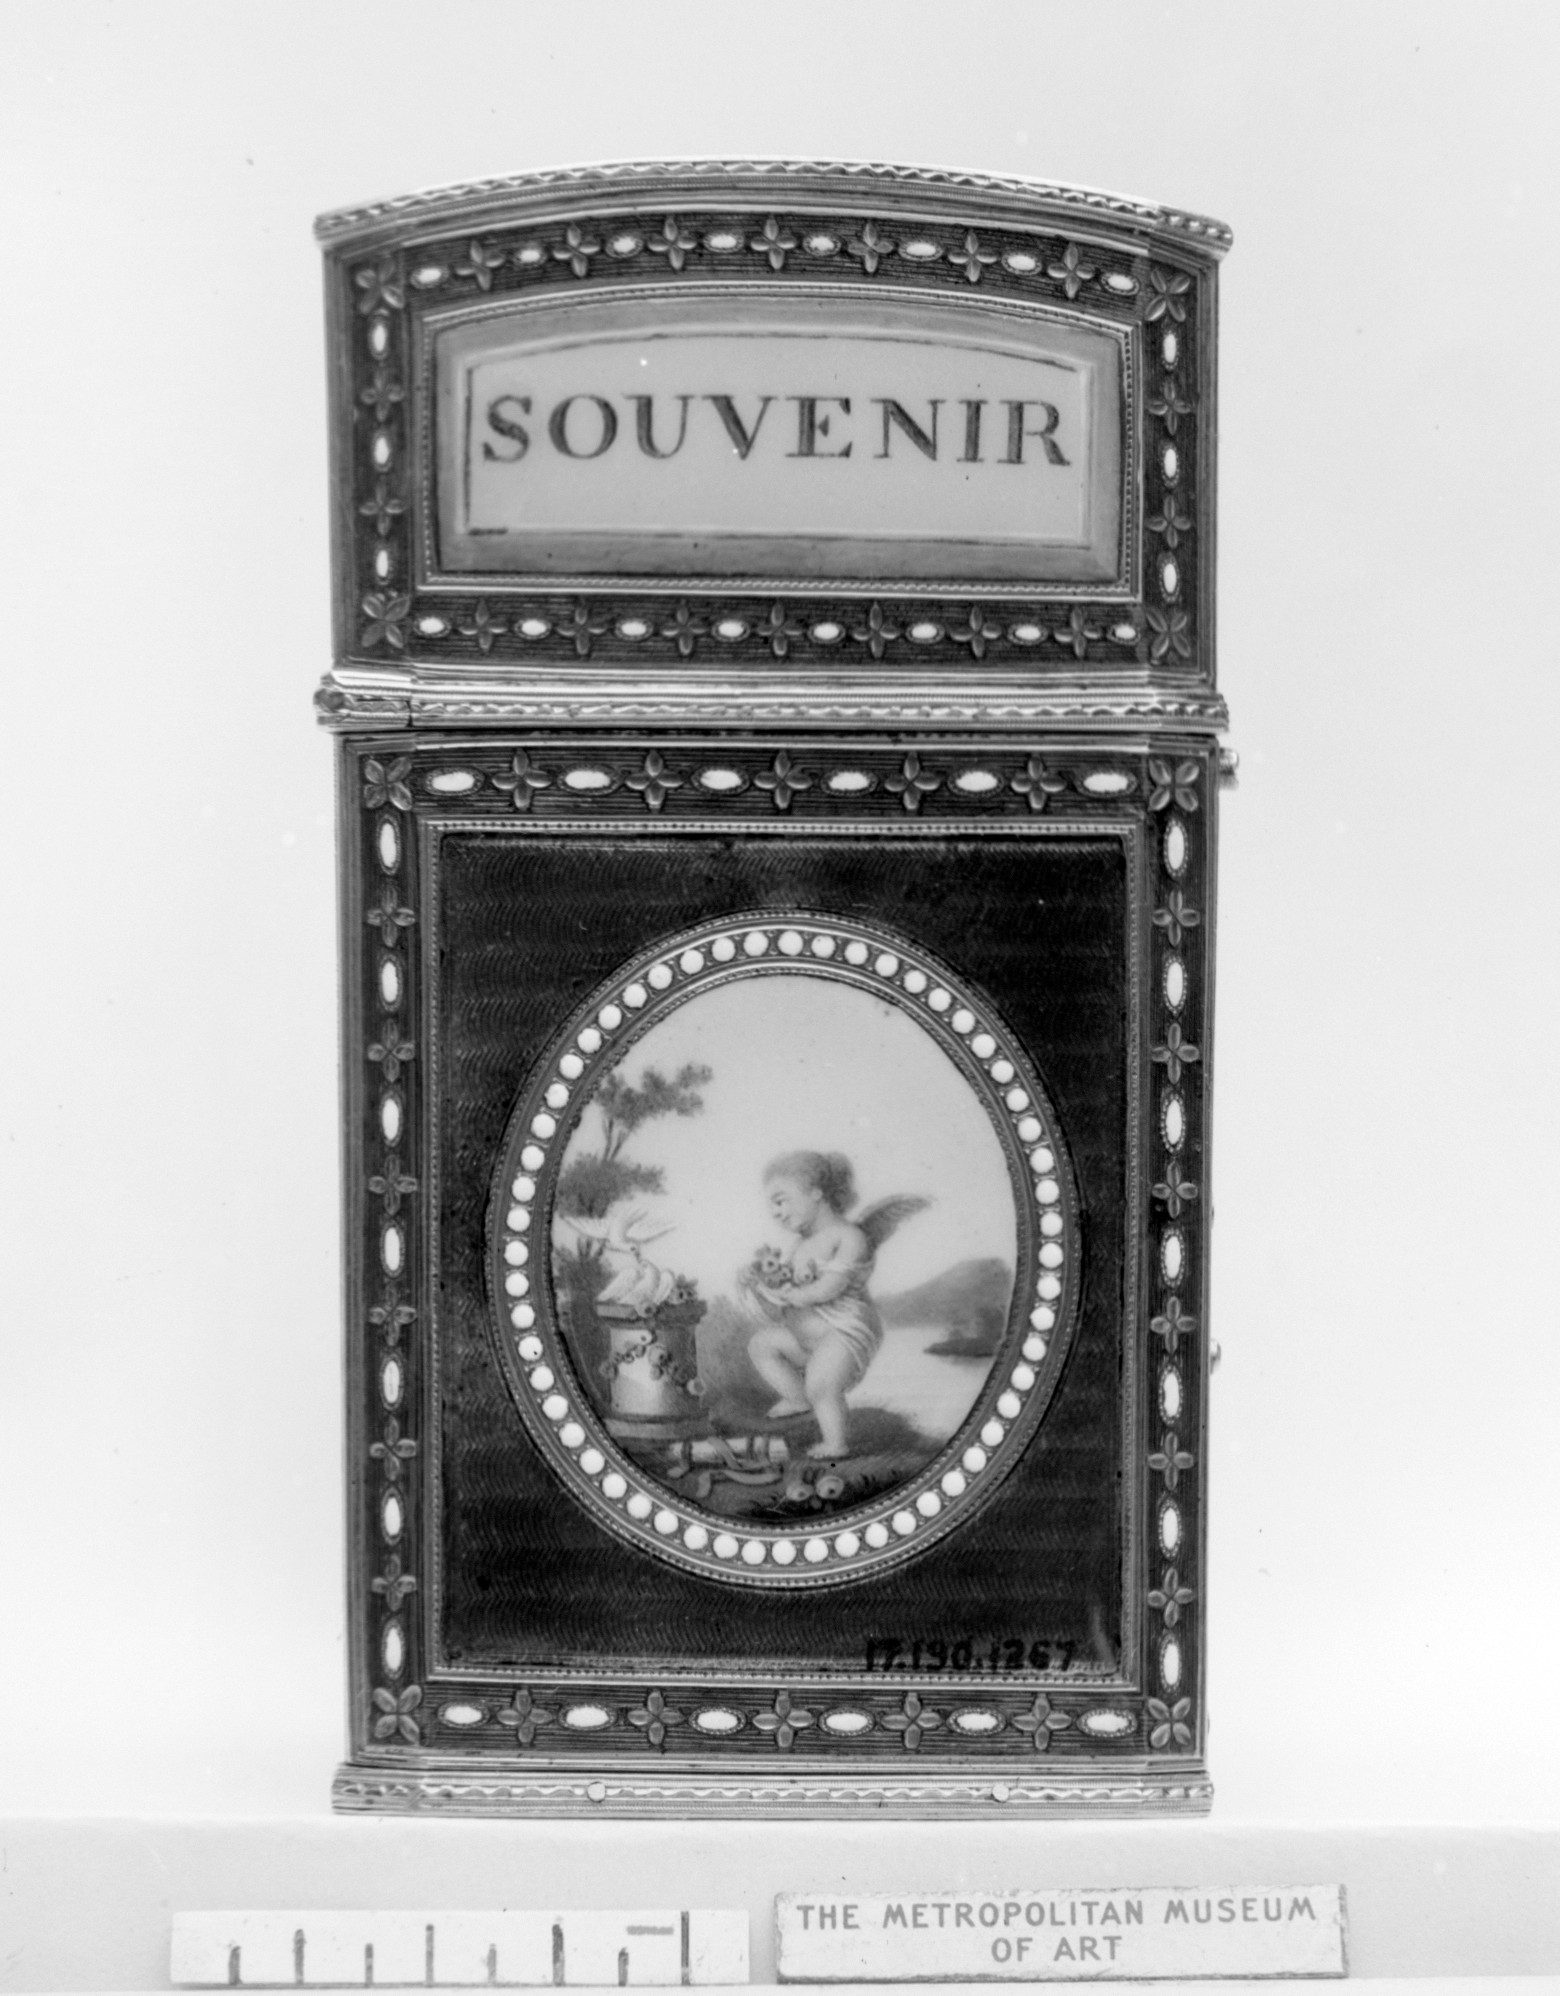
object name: souvenir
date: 1825-1840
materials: enamel, glass, gold, ivory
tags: cupid